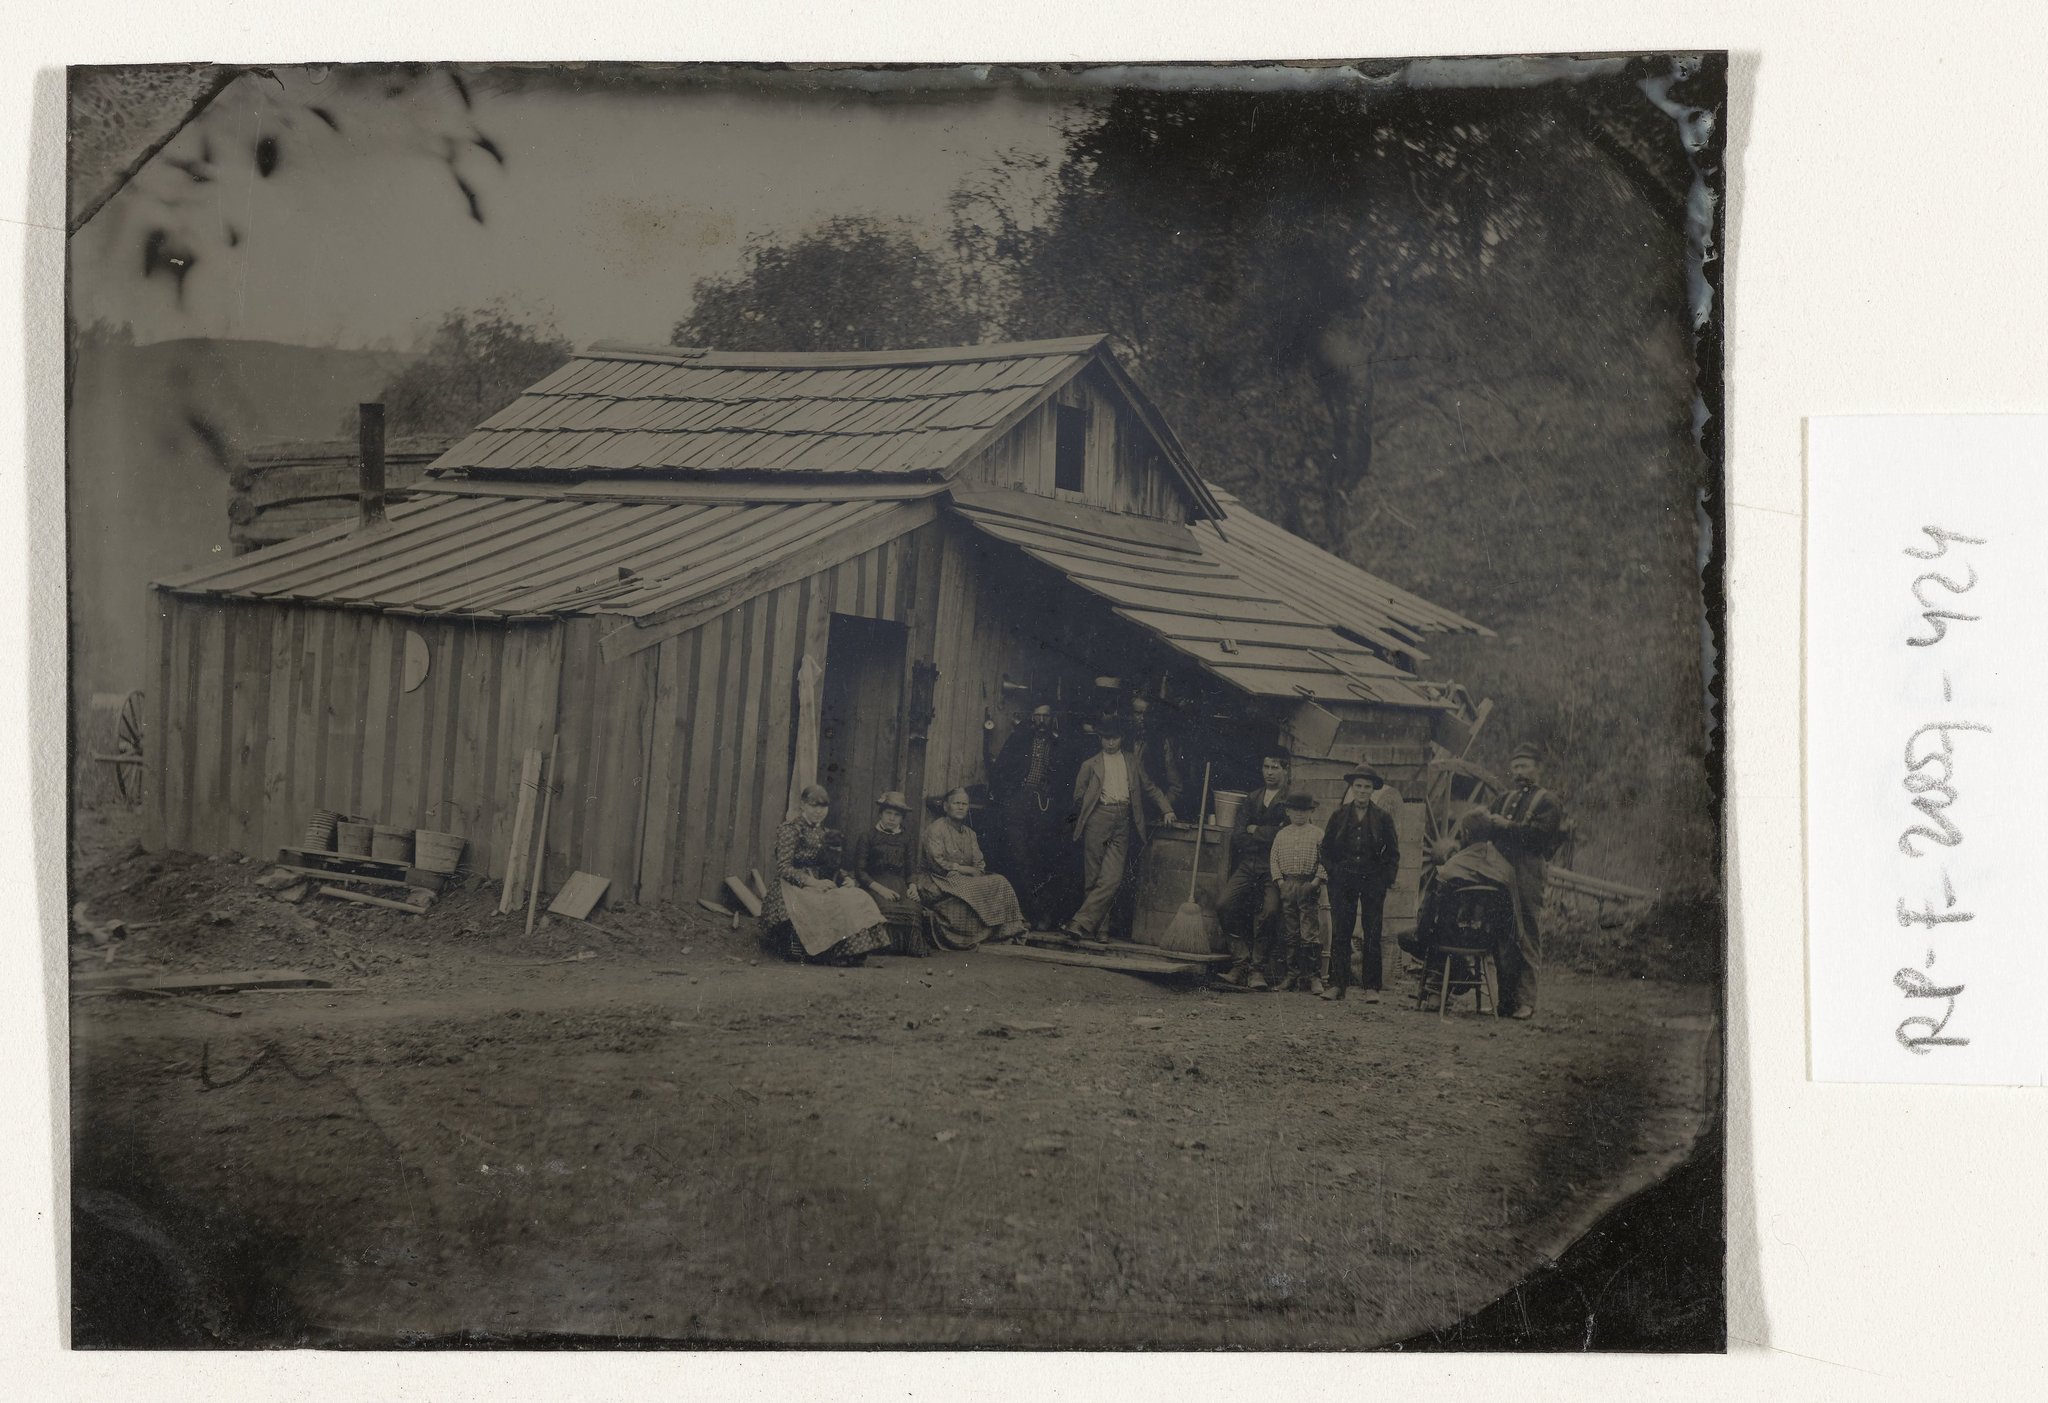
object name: photograph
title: Gezicht op een houten huis met tien personen, van wie er een geknipt en/of geschoren wordt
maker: Anonymous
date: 1870-1900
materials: metal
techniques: ferrotyping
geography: united states